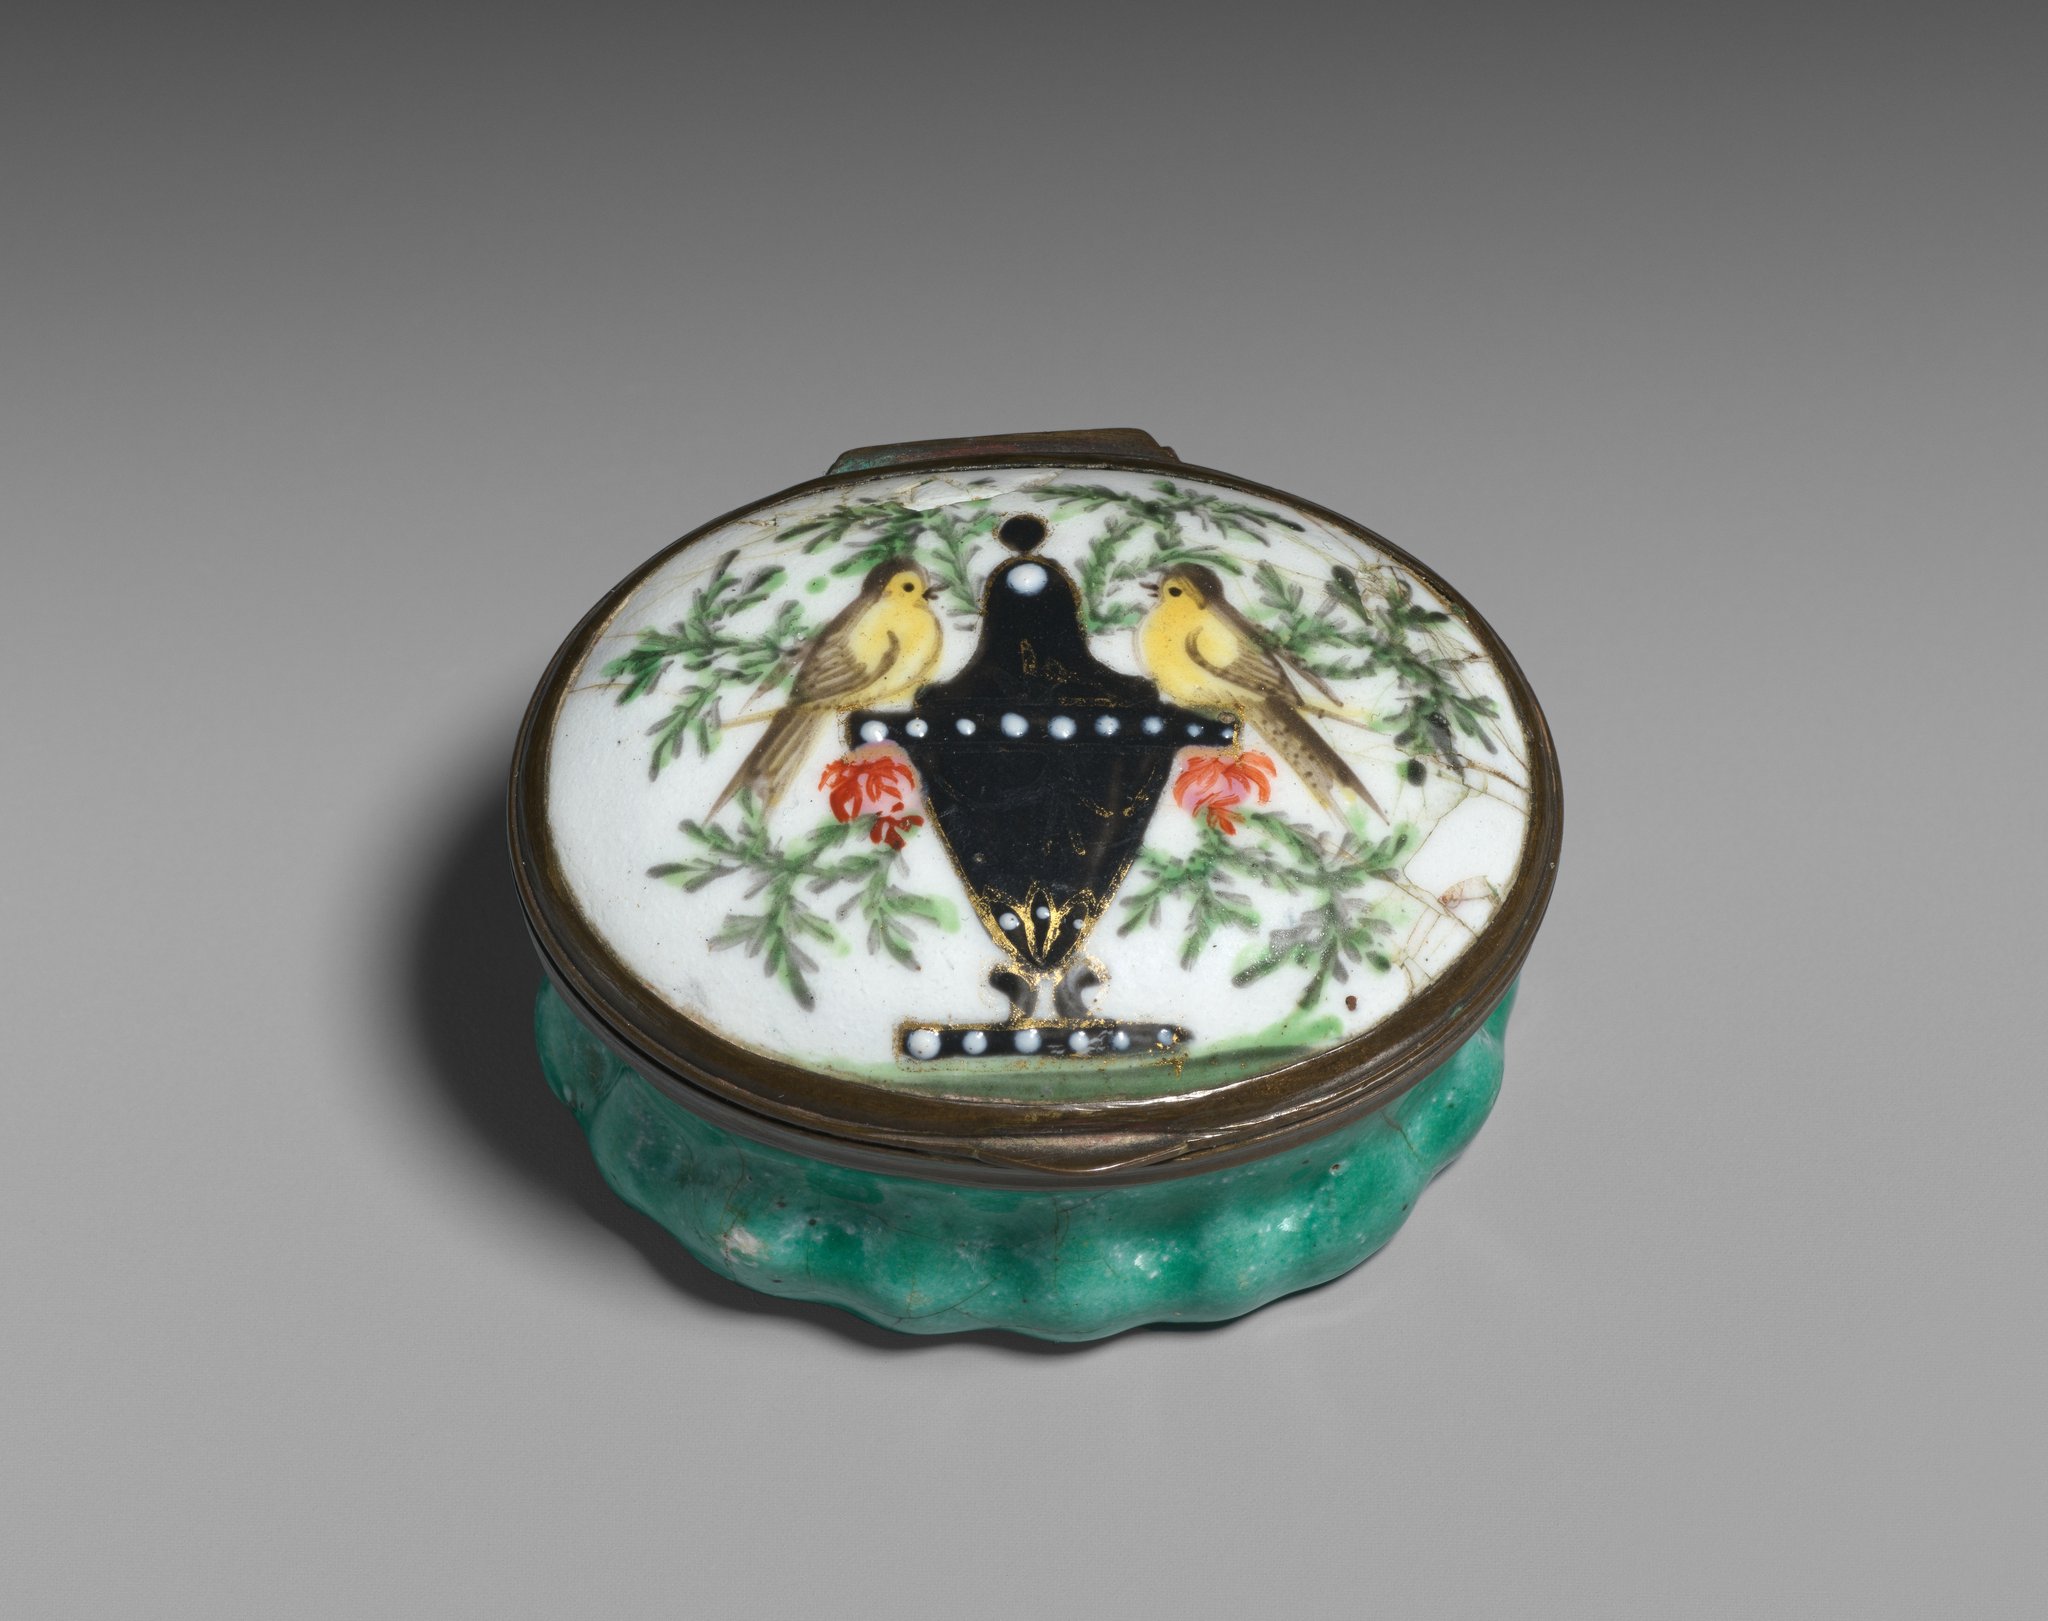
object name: patch box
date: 1780-1790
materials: copper, enamel, glass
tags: birds